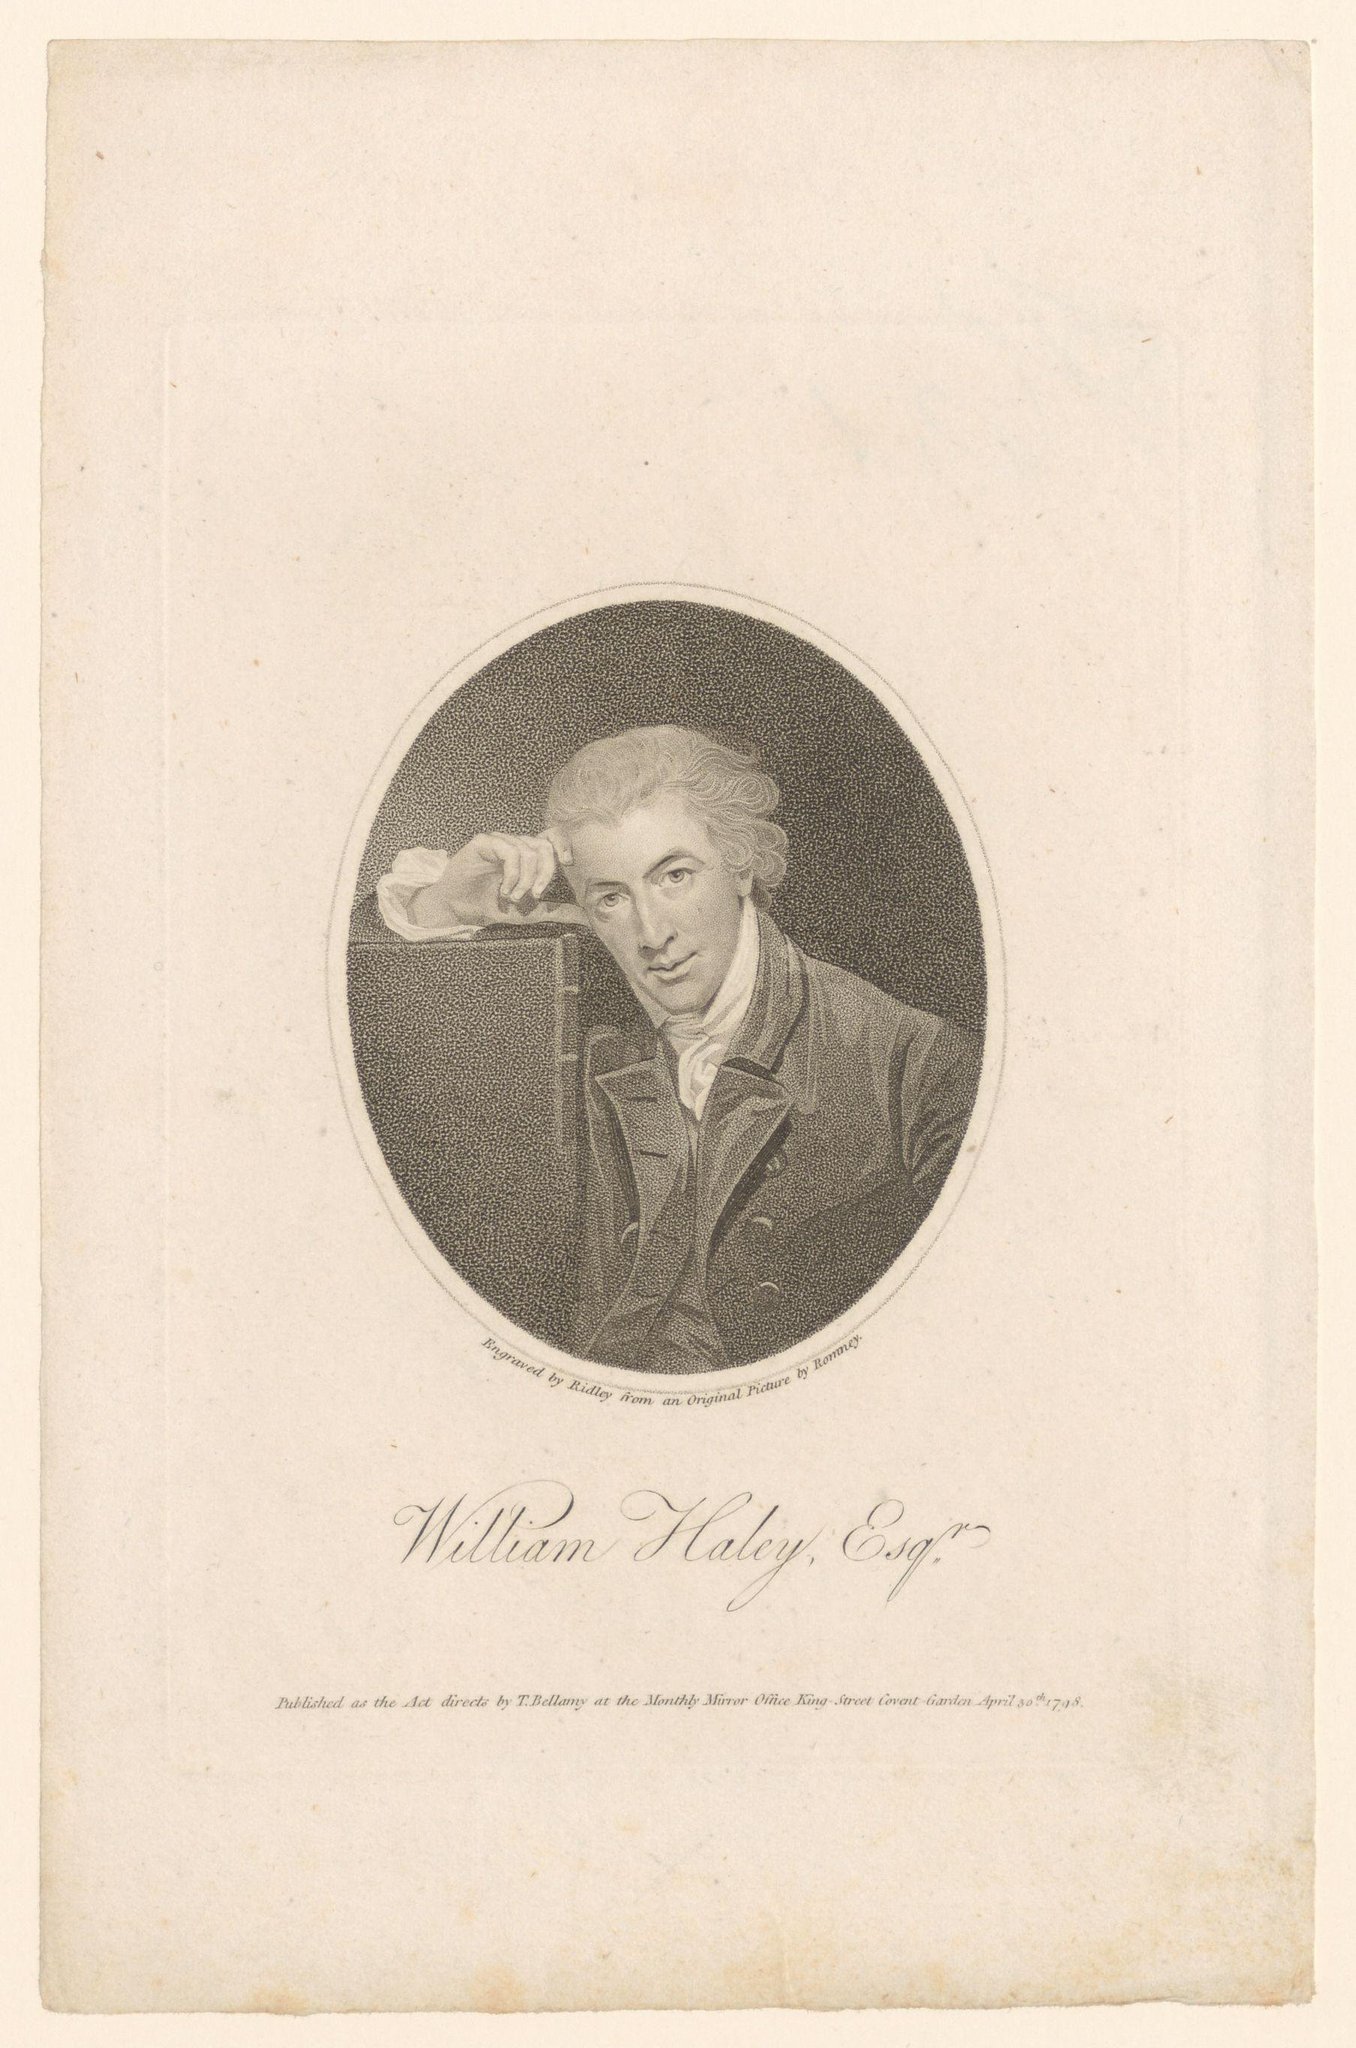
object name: print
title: Portret van William Hayley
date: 1798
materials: paper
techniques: stippling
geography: london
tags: historical persons, portrait of a writer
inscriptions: collector's mark: Lugt 2228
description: Prent gebruikt in: Monthly Mirror, 1798.